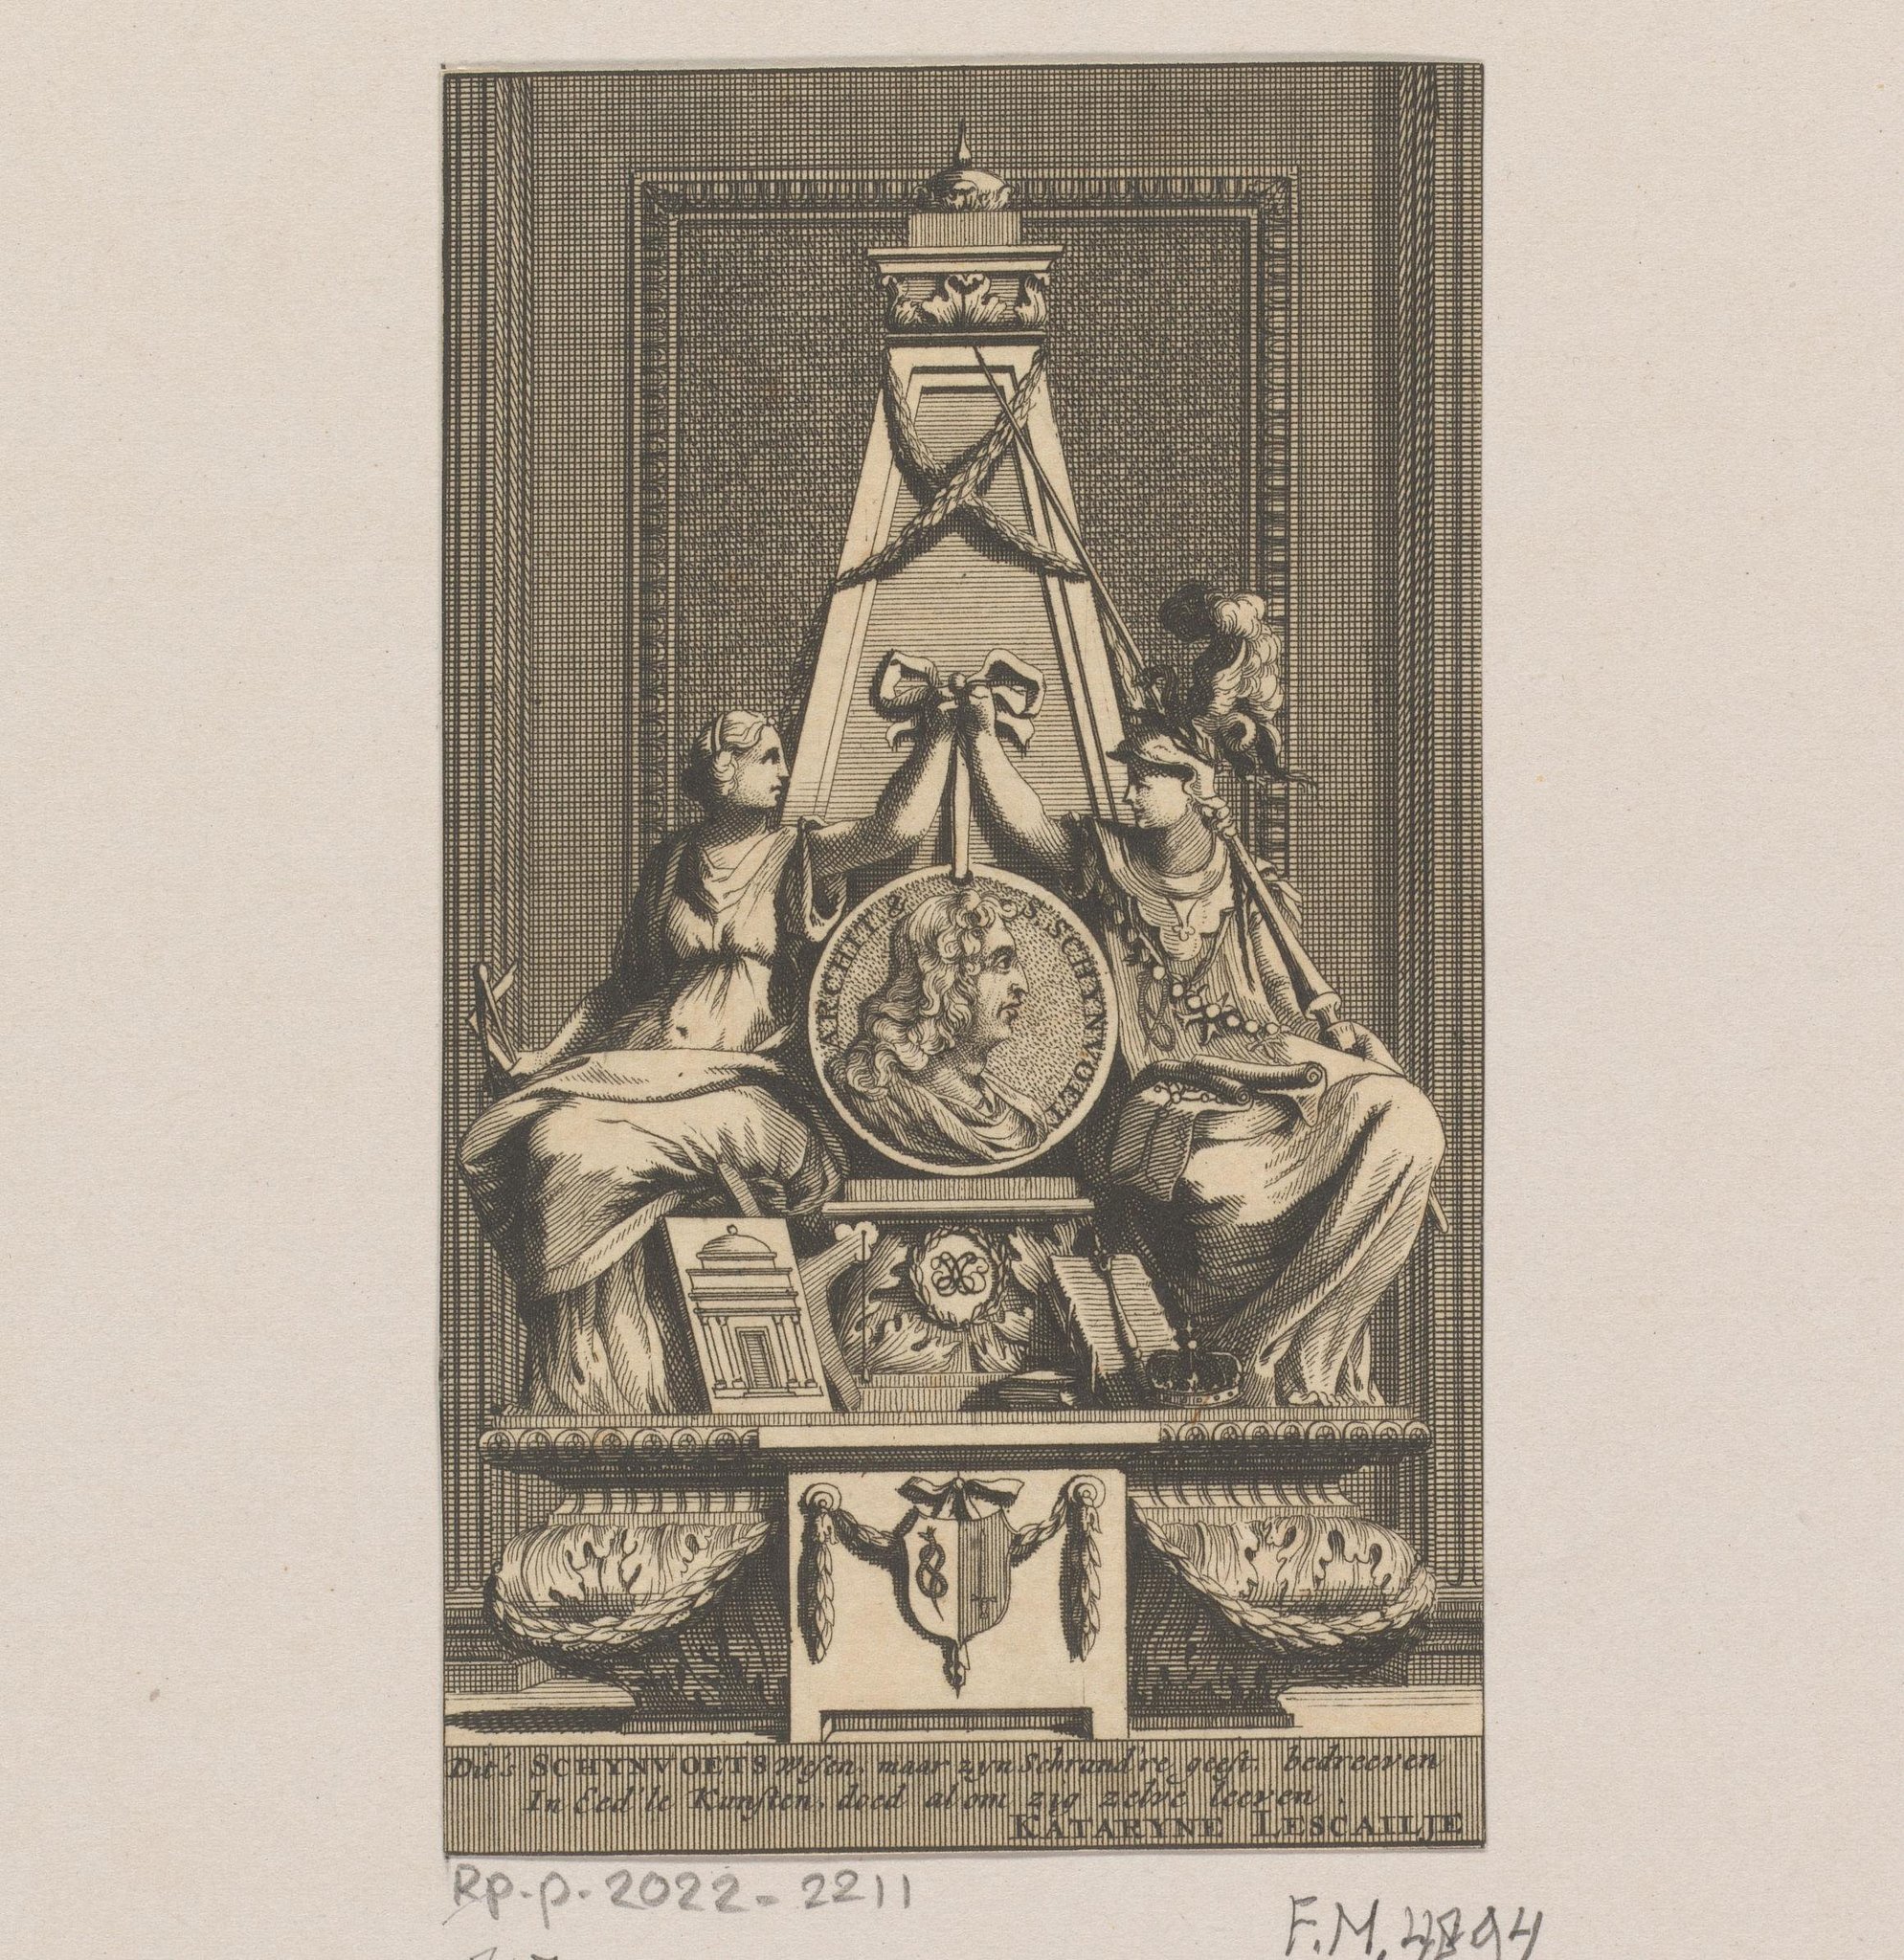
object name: print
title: Grafmonument voor Simon Schijnvoet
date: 1727-1750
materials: paper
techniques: engraving, etching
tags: the hague, amsterdam, simon schijnvoet, historical persons, monument, statue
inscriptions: inscription: ‘[...] 24 Oct 1727’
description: Met tweeregelig onderschrift in het Nederlands.